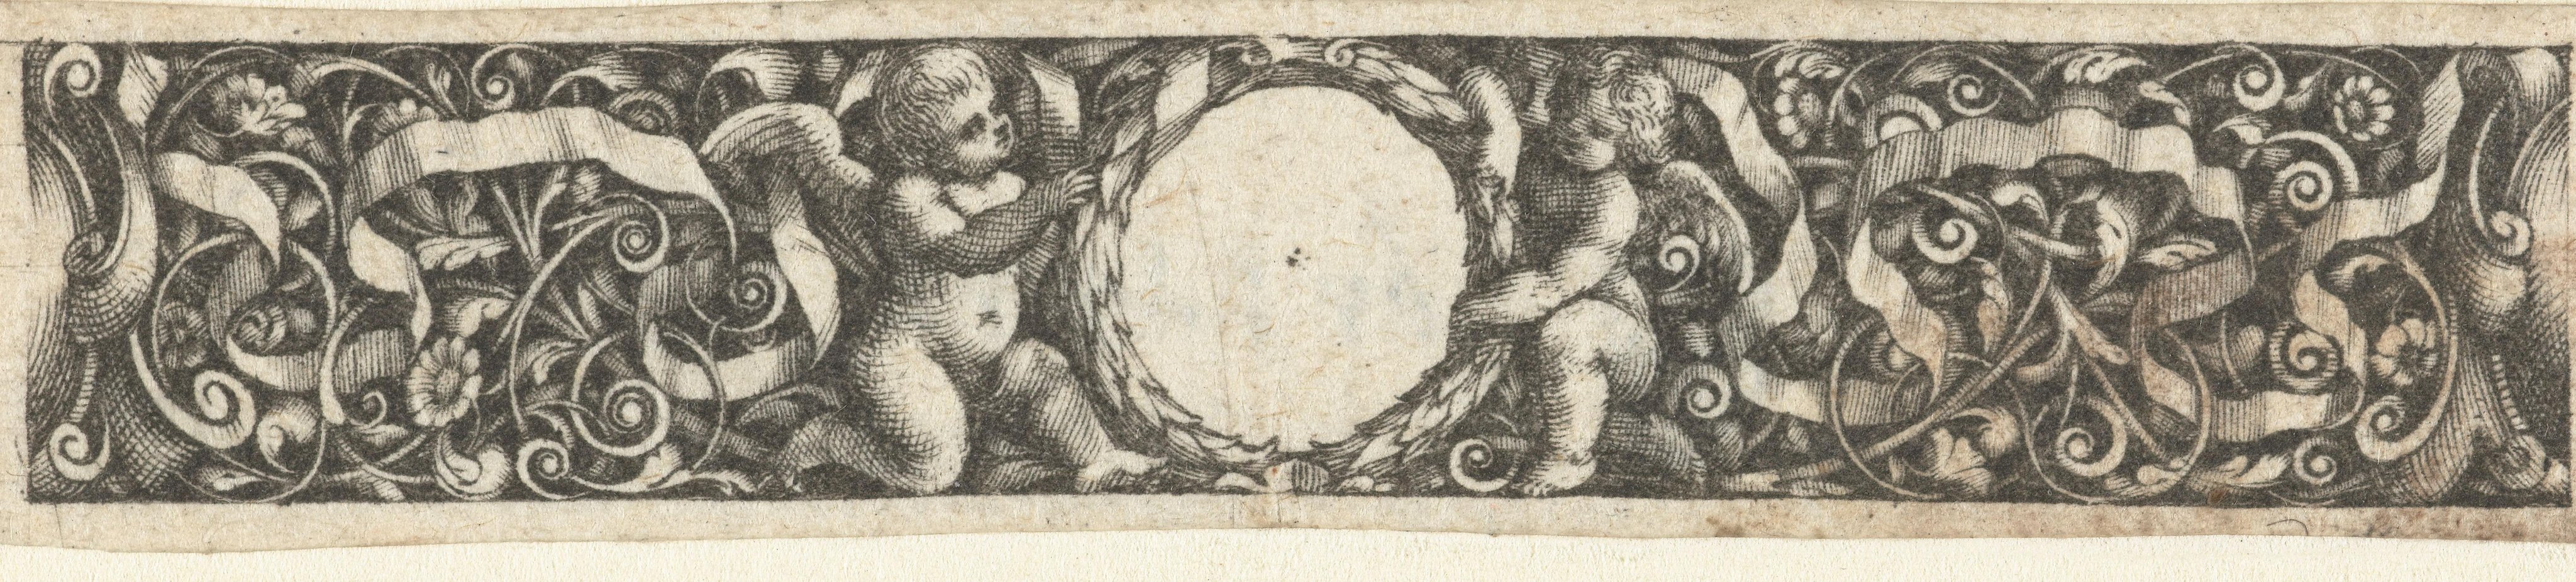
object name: print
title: Ontwerpen voor edelsmeden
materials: paper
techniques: engraving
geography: france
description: Putti die een lauwerkrans vasthouden met op de achtergrond bladranken en linten.